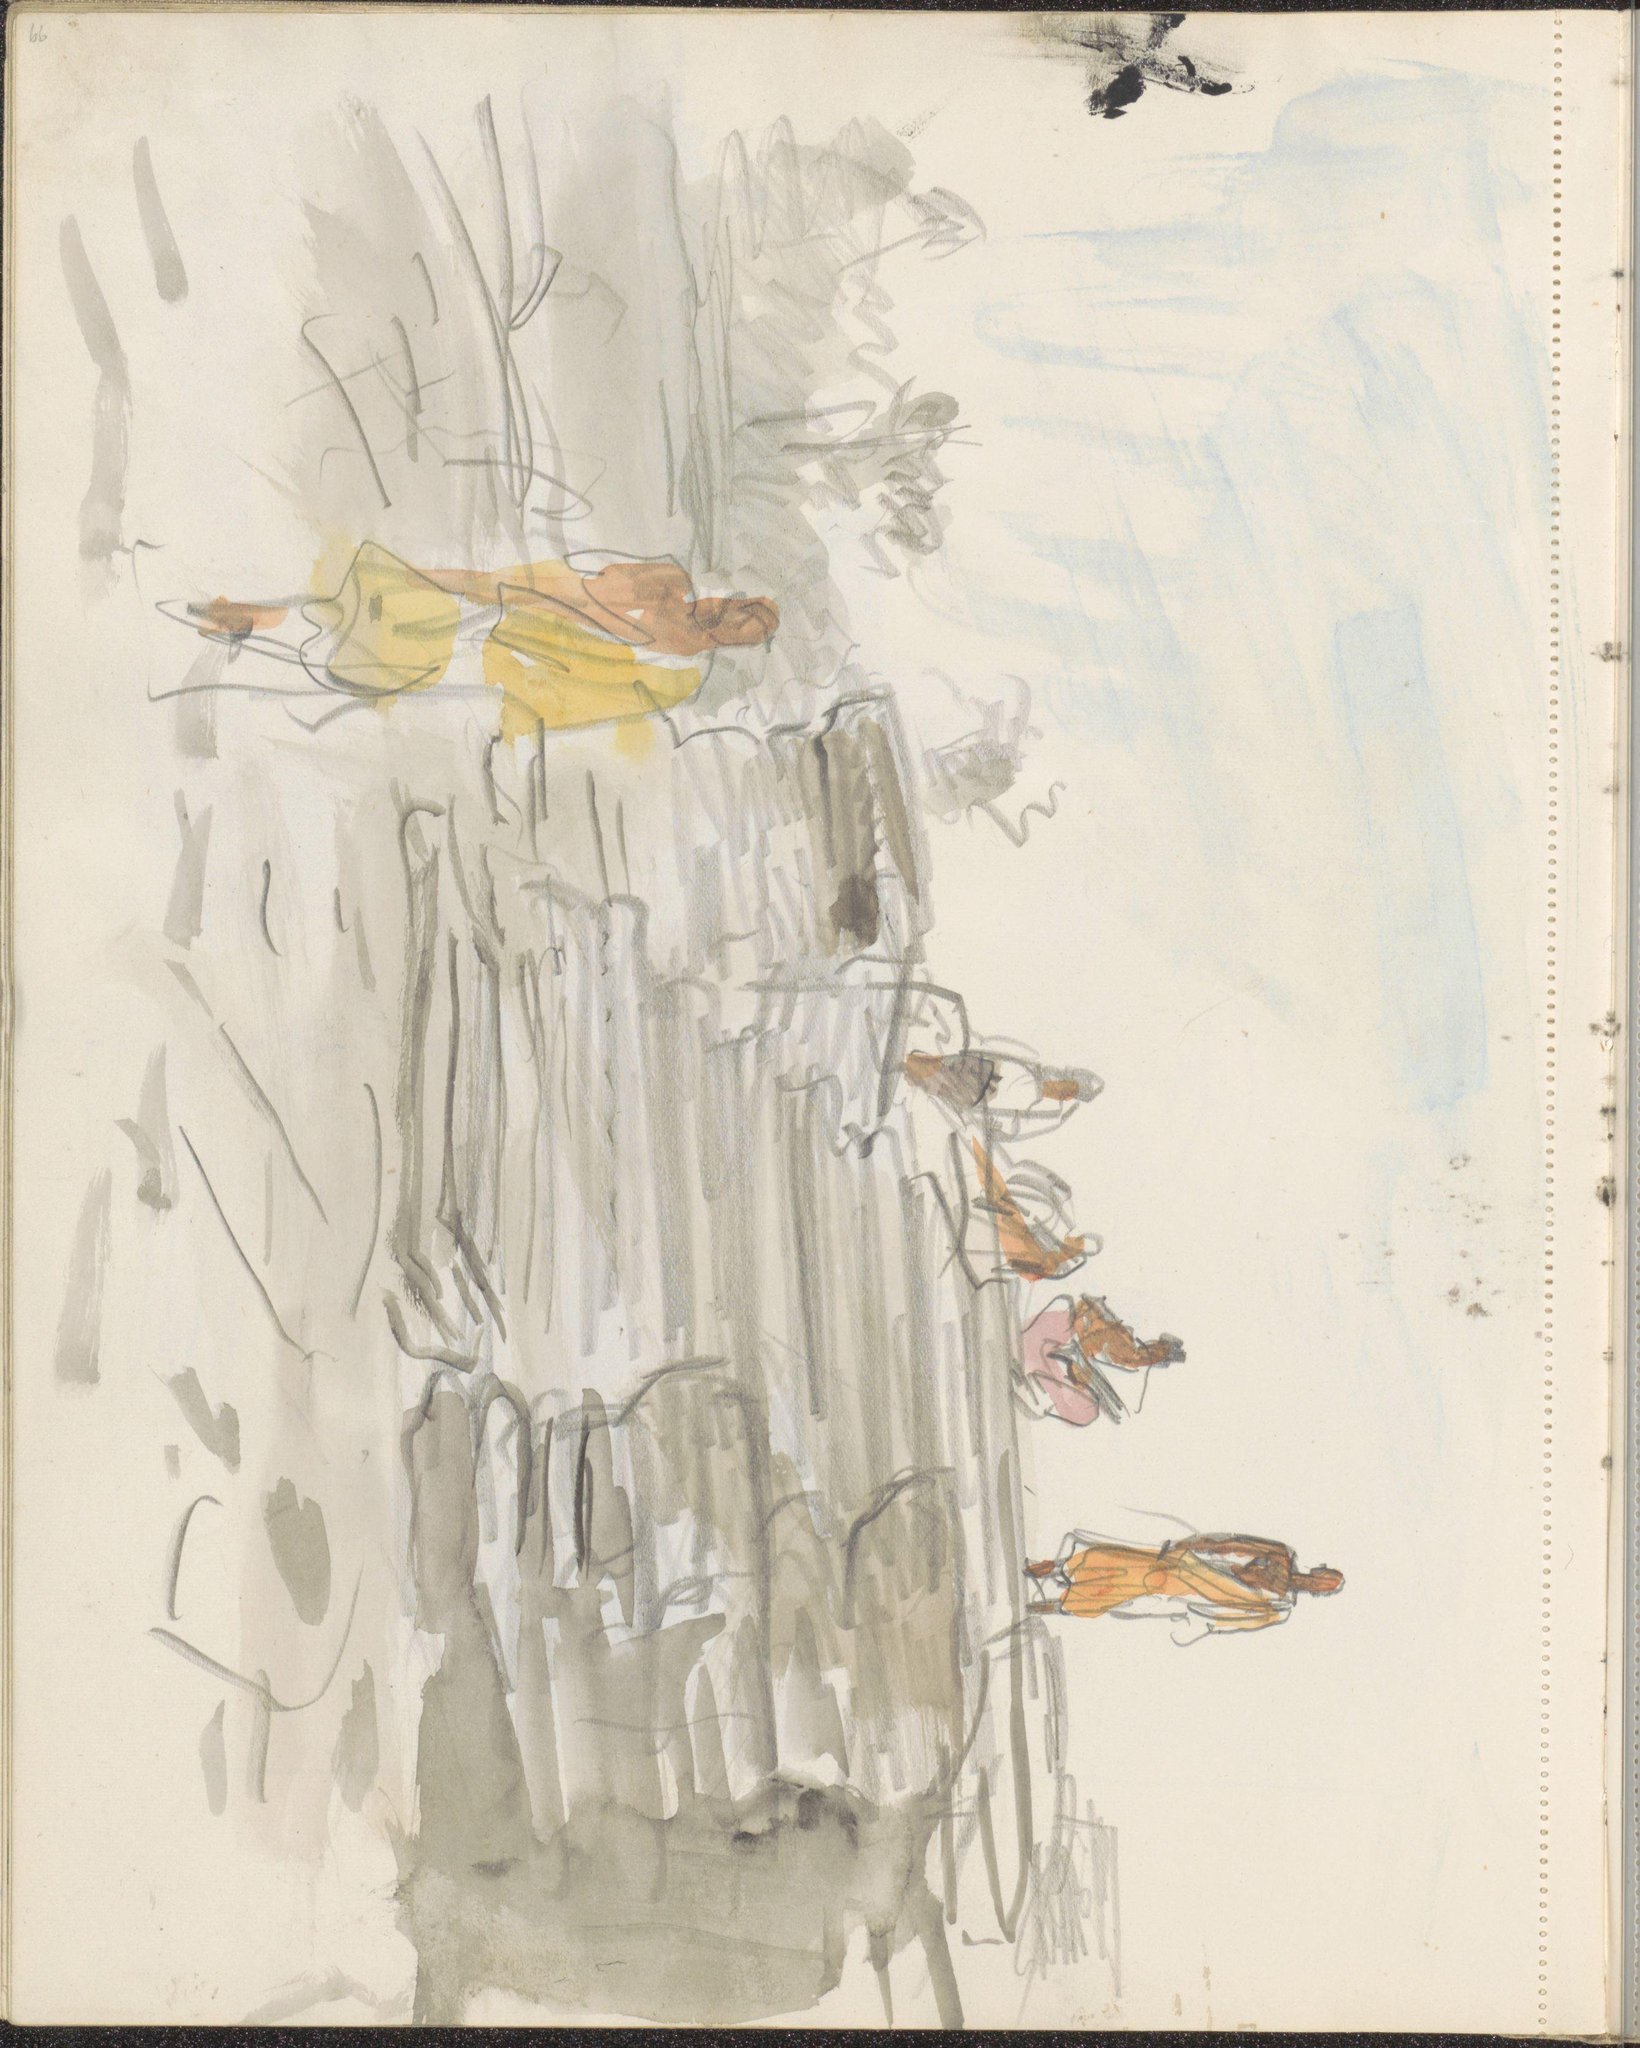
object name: sketchbook leaf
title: Figuren, waaronder twee Boeddhistische monniken, op een trap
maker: marius bauer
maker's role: draughtsman, print maker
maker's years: 1867-1932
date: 1931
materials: paper, pencil, watercolor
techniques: brush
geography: cambodia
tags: sitting figure, flight of steps, squatting, crouching figure, religious functionaries ~ hinduism, buddhism, jainism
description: Vermoedelijk een trap bij de Angkor Wat tempel in Cambodja. Pagina 66 uit een schetsboek met 48 bladen.